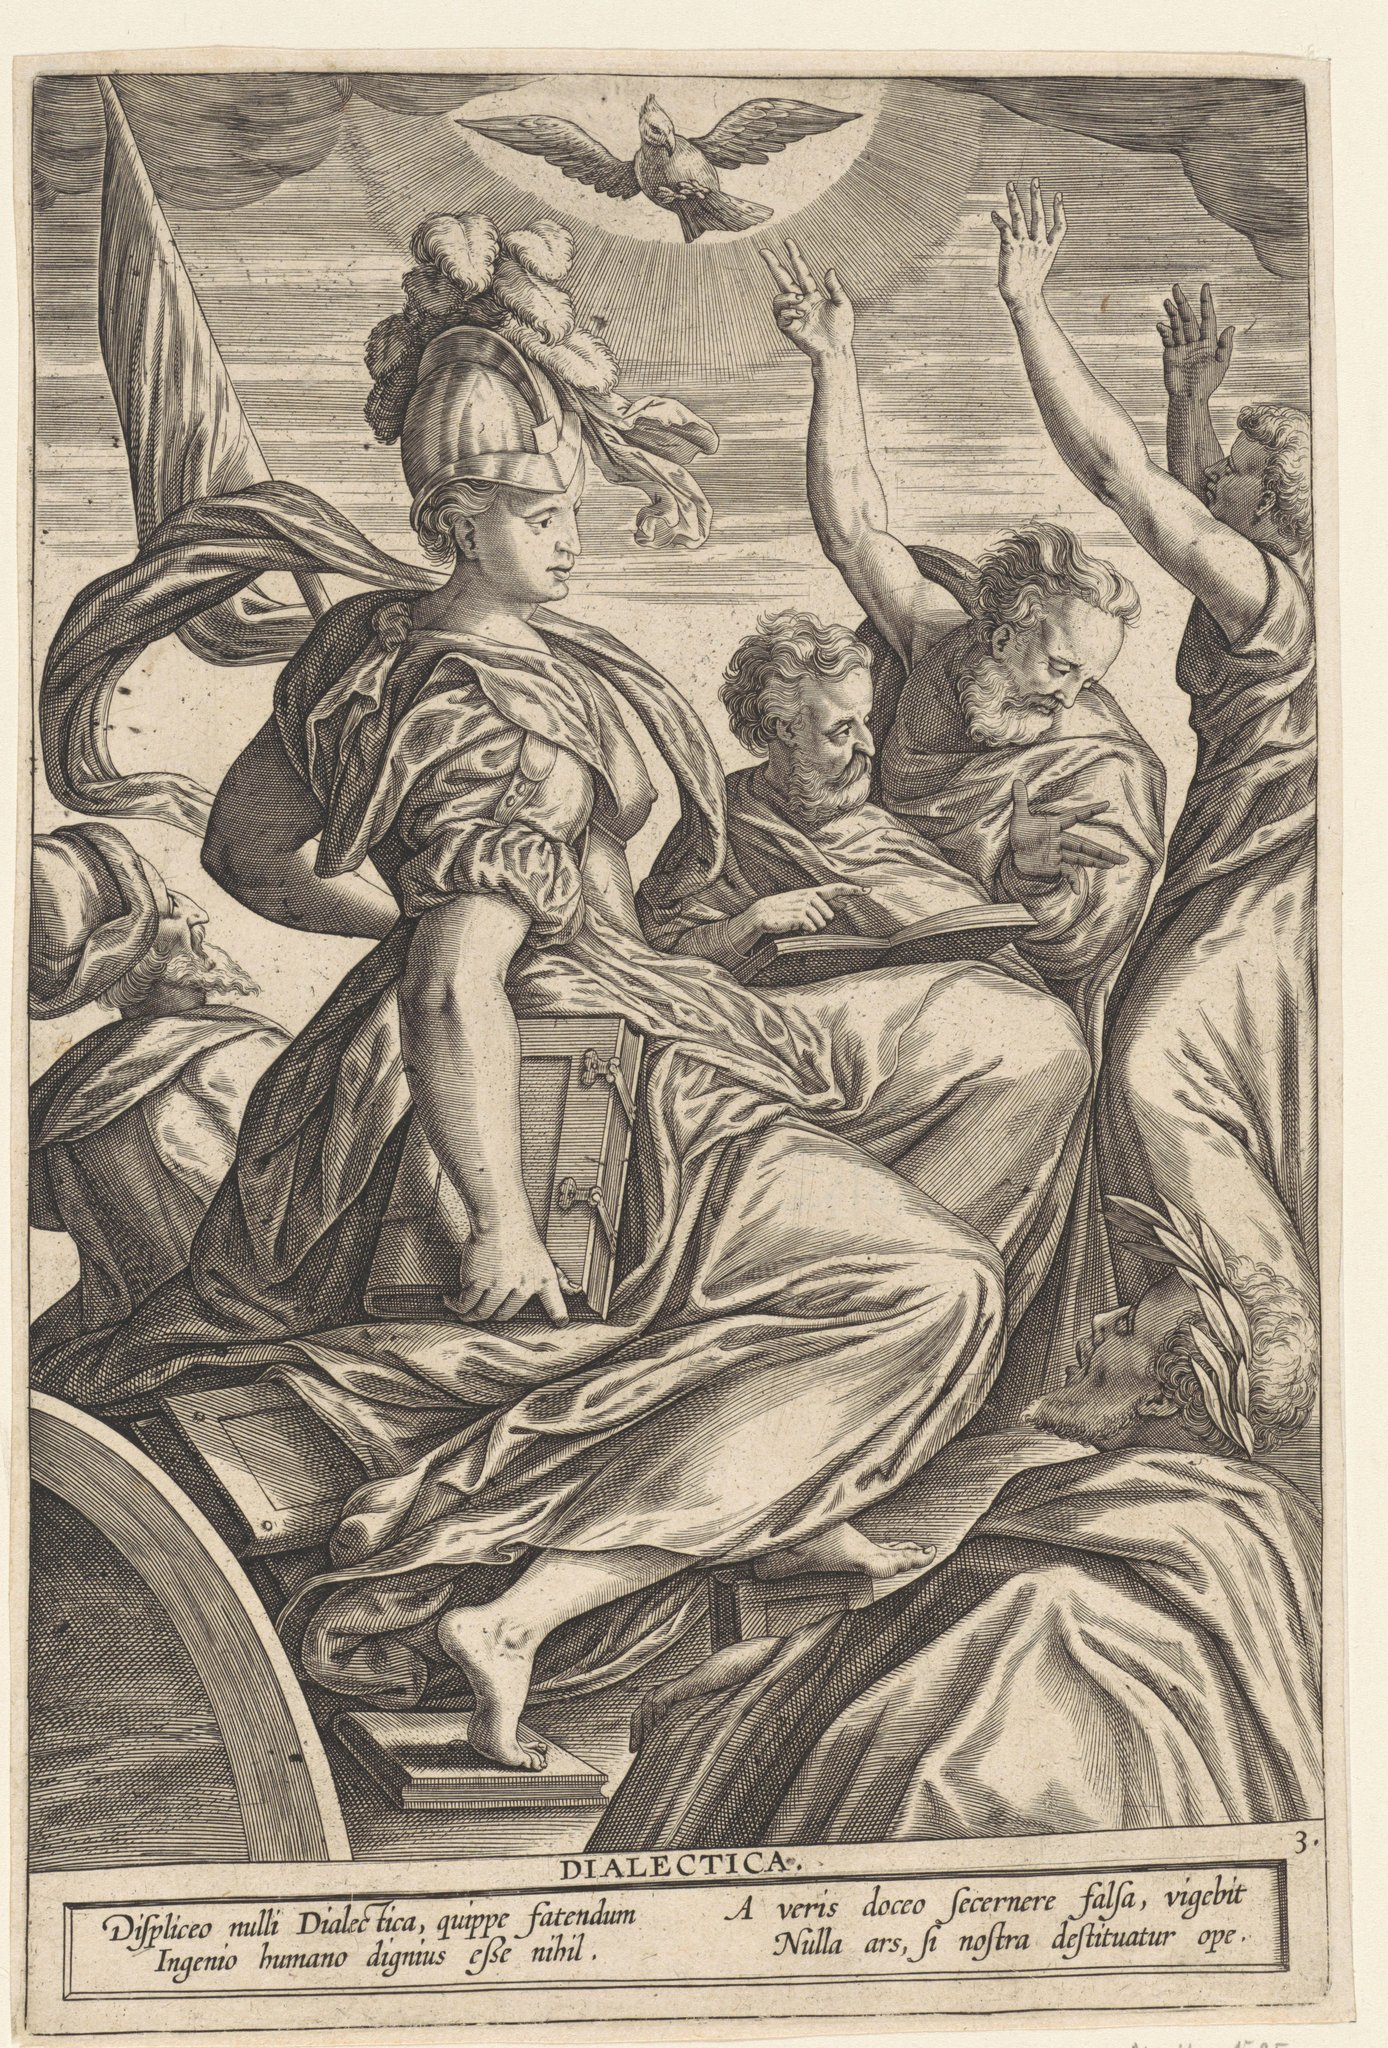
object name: print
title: Dialectica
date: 1592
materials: paper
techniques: engraving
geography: antwerp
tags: 'dialectica' (~ trivium); 'dialettica' (ripa), holy ghost represented as a dove (in flames)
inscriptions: collector's mark: Lugt 2228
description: De vrouwelijke personificatie van Logica, een helm op het hoofd, een vaandel en een boek in de handen. Ze is omringd door wijze mannen. In de lucht de duif van de Heilige Geest. In het kader in de marge een vierregelig onderschrift, in twee kolommen, in het Latijn.